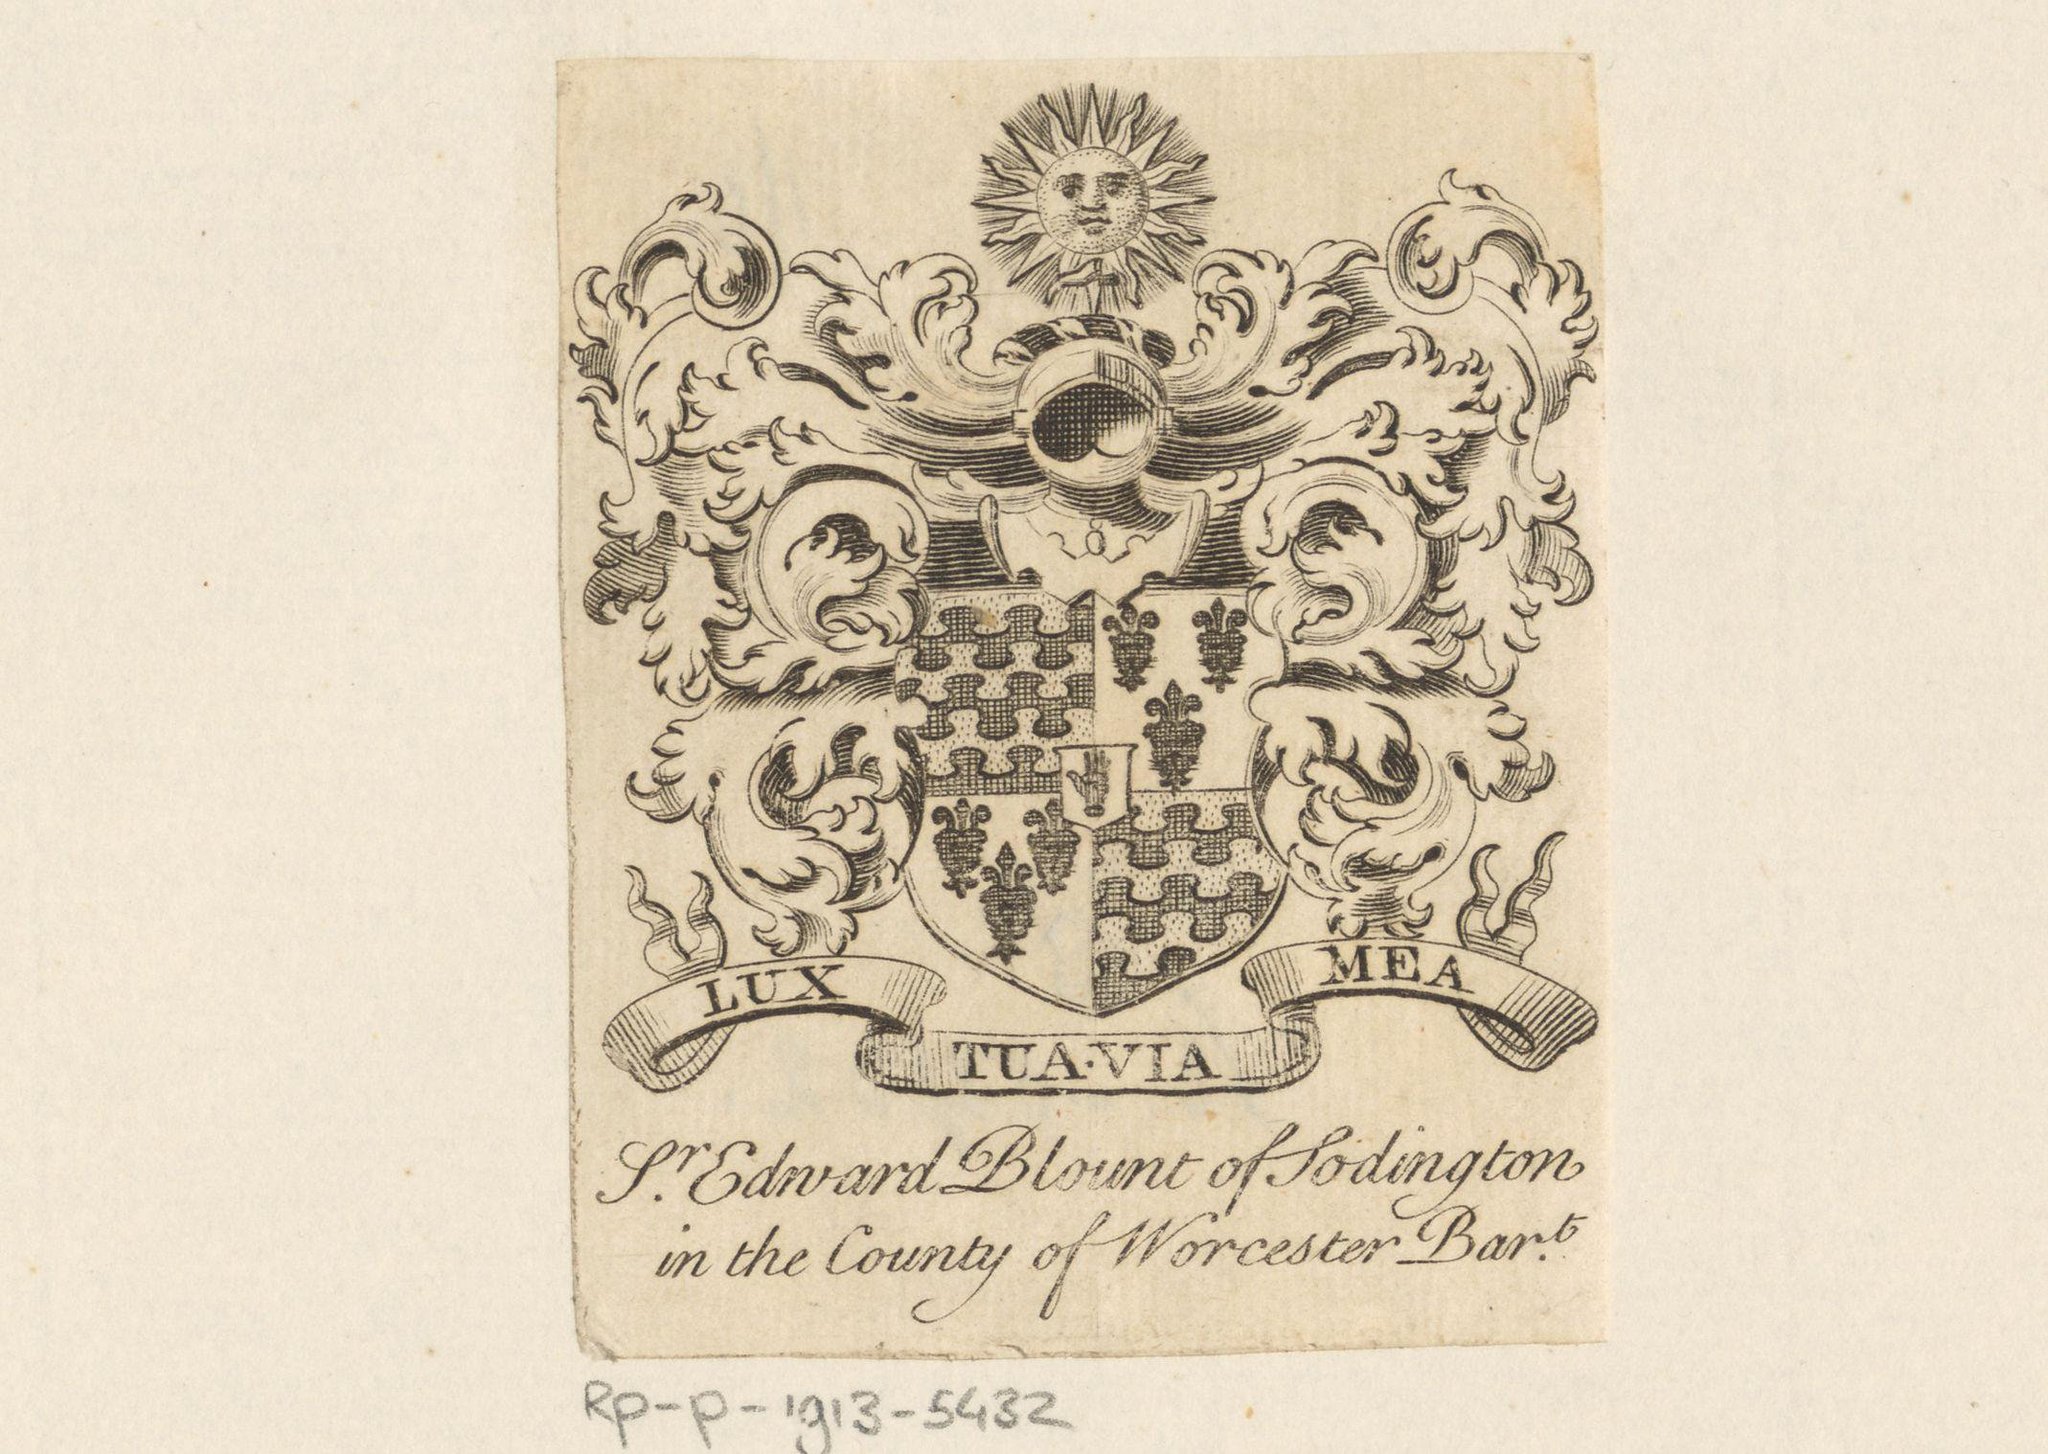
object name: bookplate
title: Ex libris van Sr. Edward Blount of Sodington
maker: Anonymous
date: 1738-1758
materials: paper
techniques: engraving, etching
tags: armorial bearing, heraldry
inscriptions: collector's mark: Lugt 2760, collector's mark: Lugt 2233